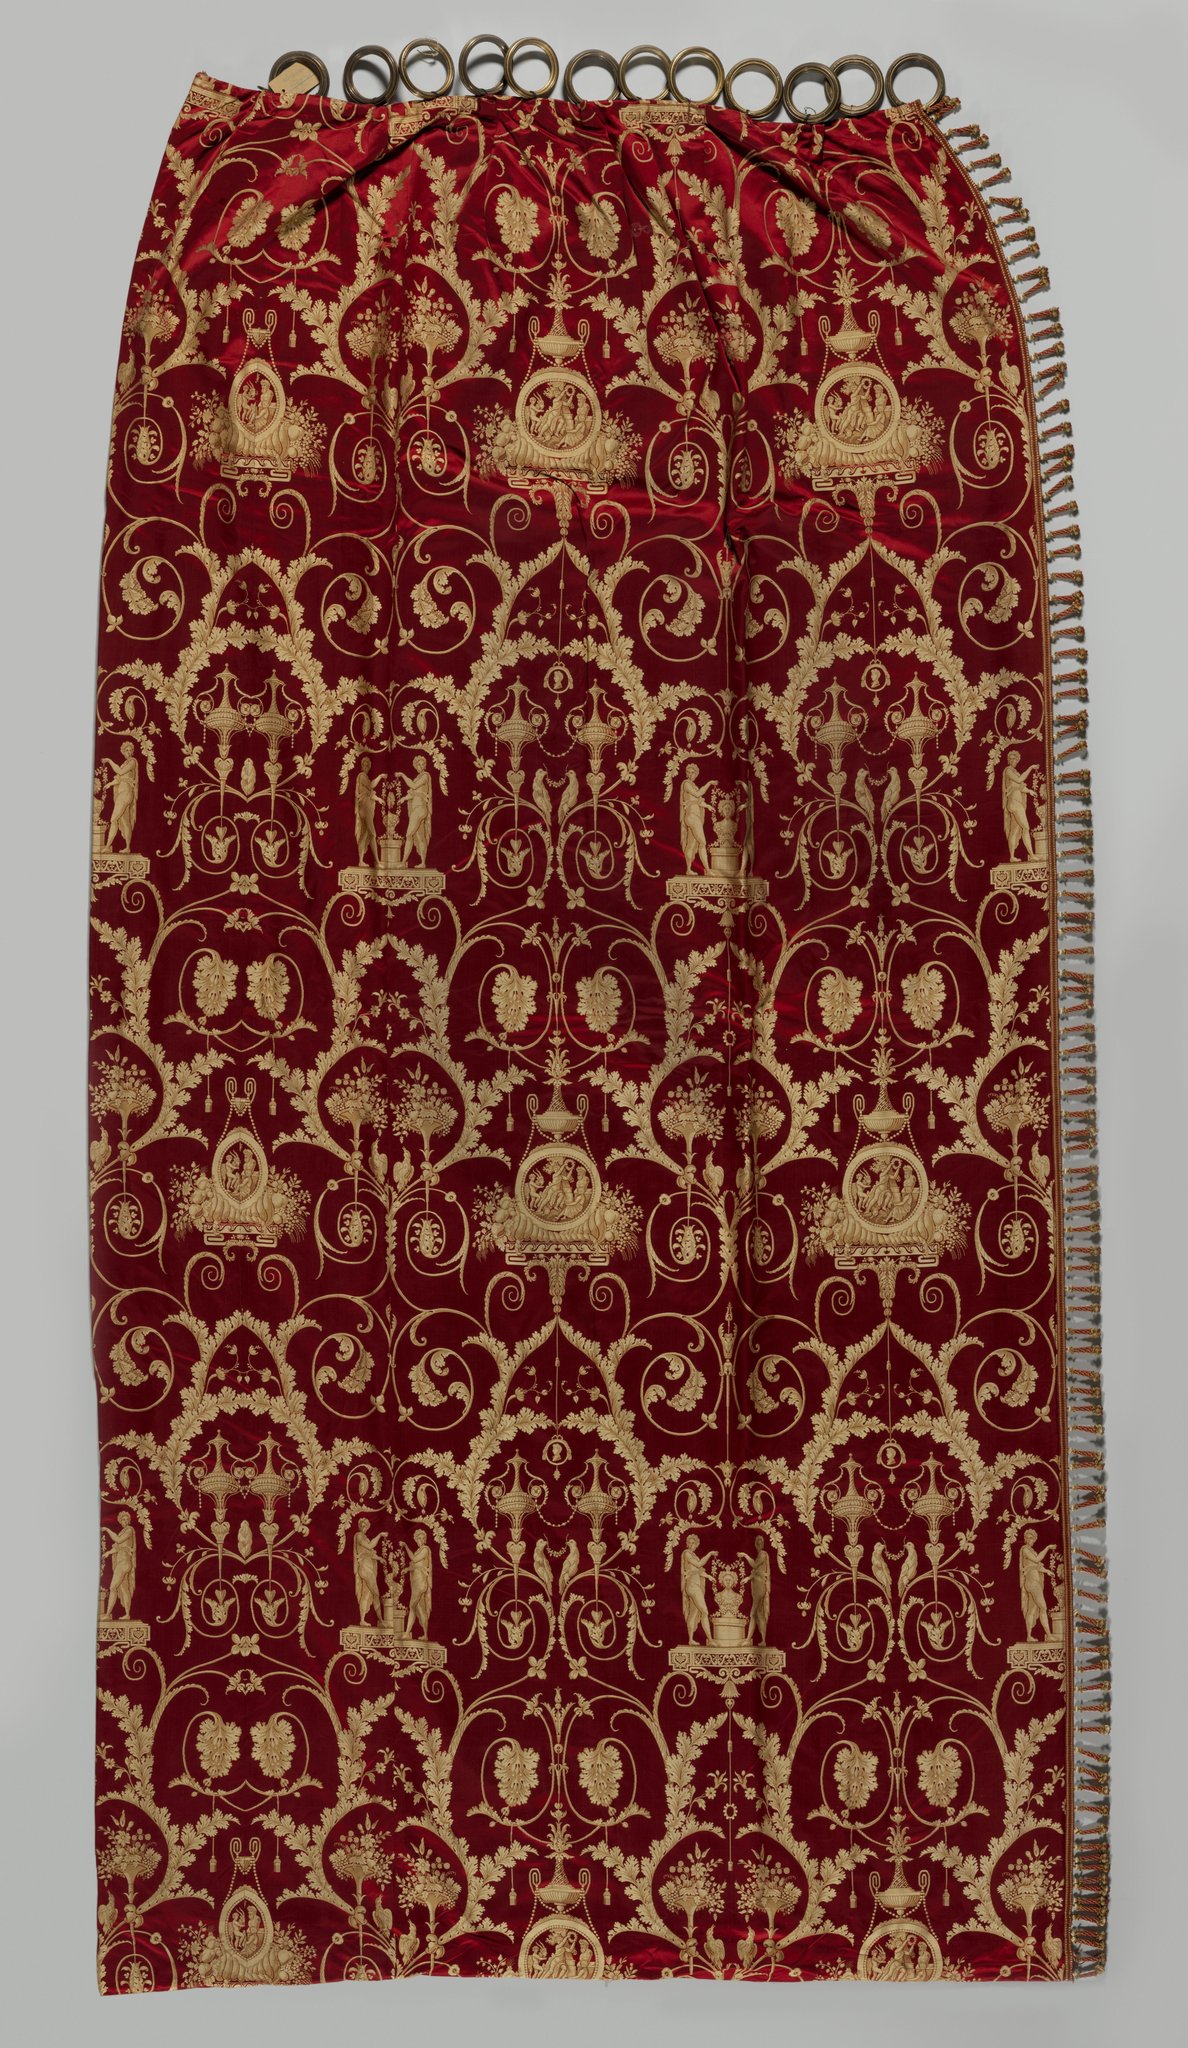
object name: curtain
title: Gordijn met imitatiestijl Directoire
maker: Anonymous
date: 1800-1825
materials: brass, cotton, textile, silk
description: Gordijn met groteskenpatroon van medaillons, portretbustes, vazen en voluutranken in crème tegen een satijnen ondergrond in donker steenrood. Neo-Pompeiaans. Rode voering. Met grote, geprofileerde ringen en franjes langs één kant.